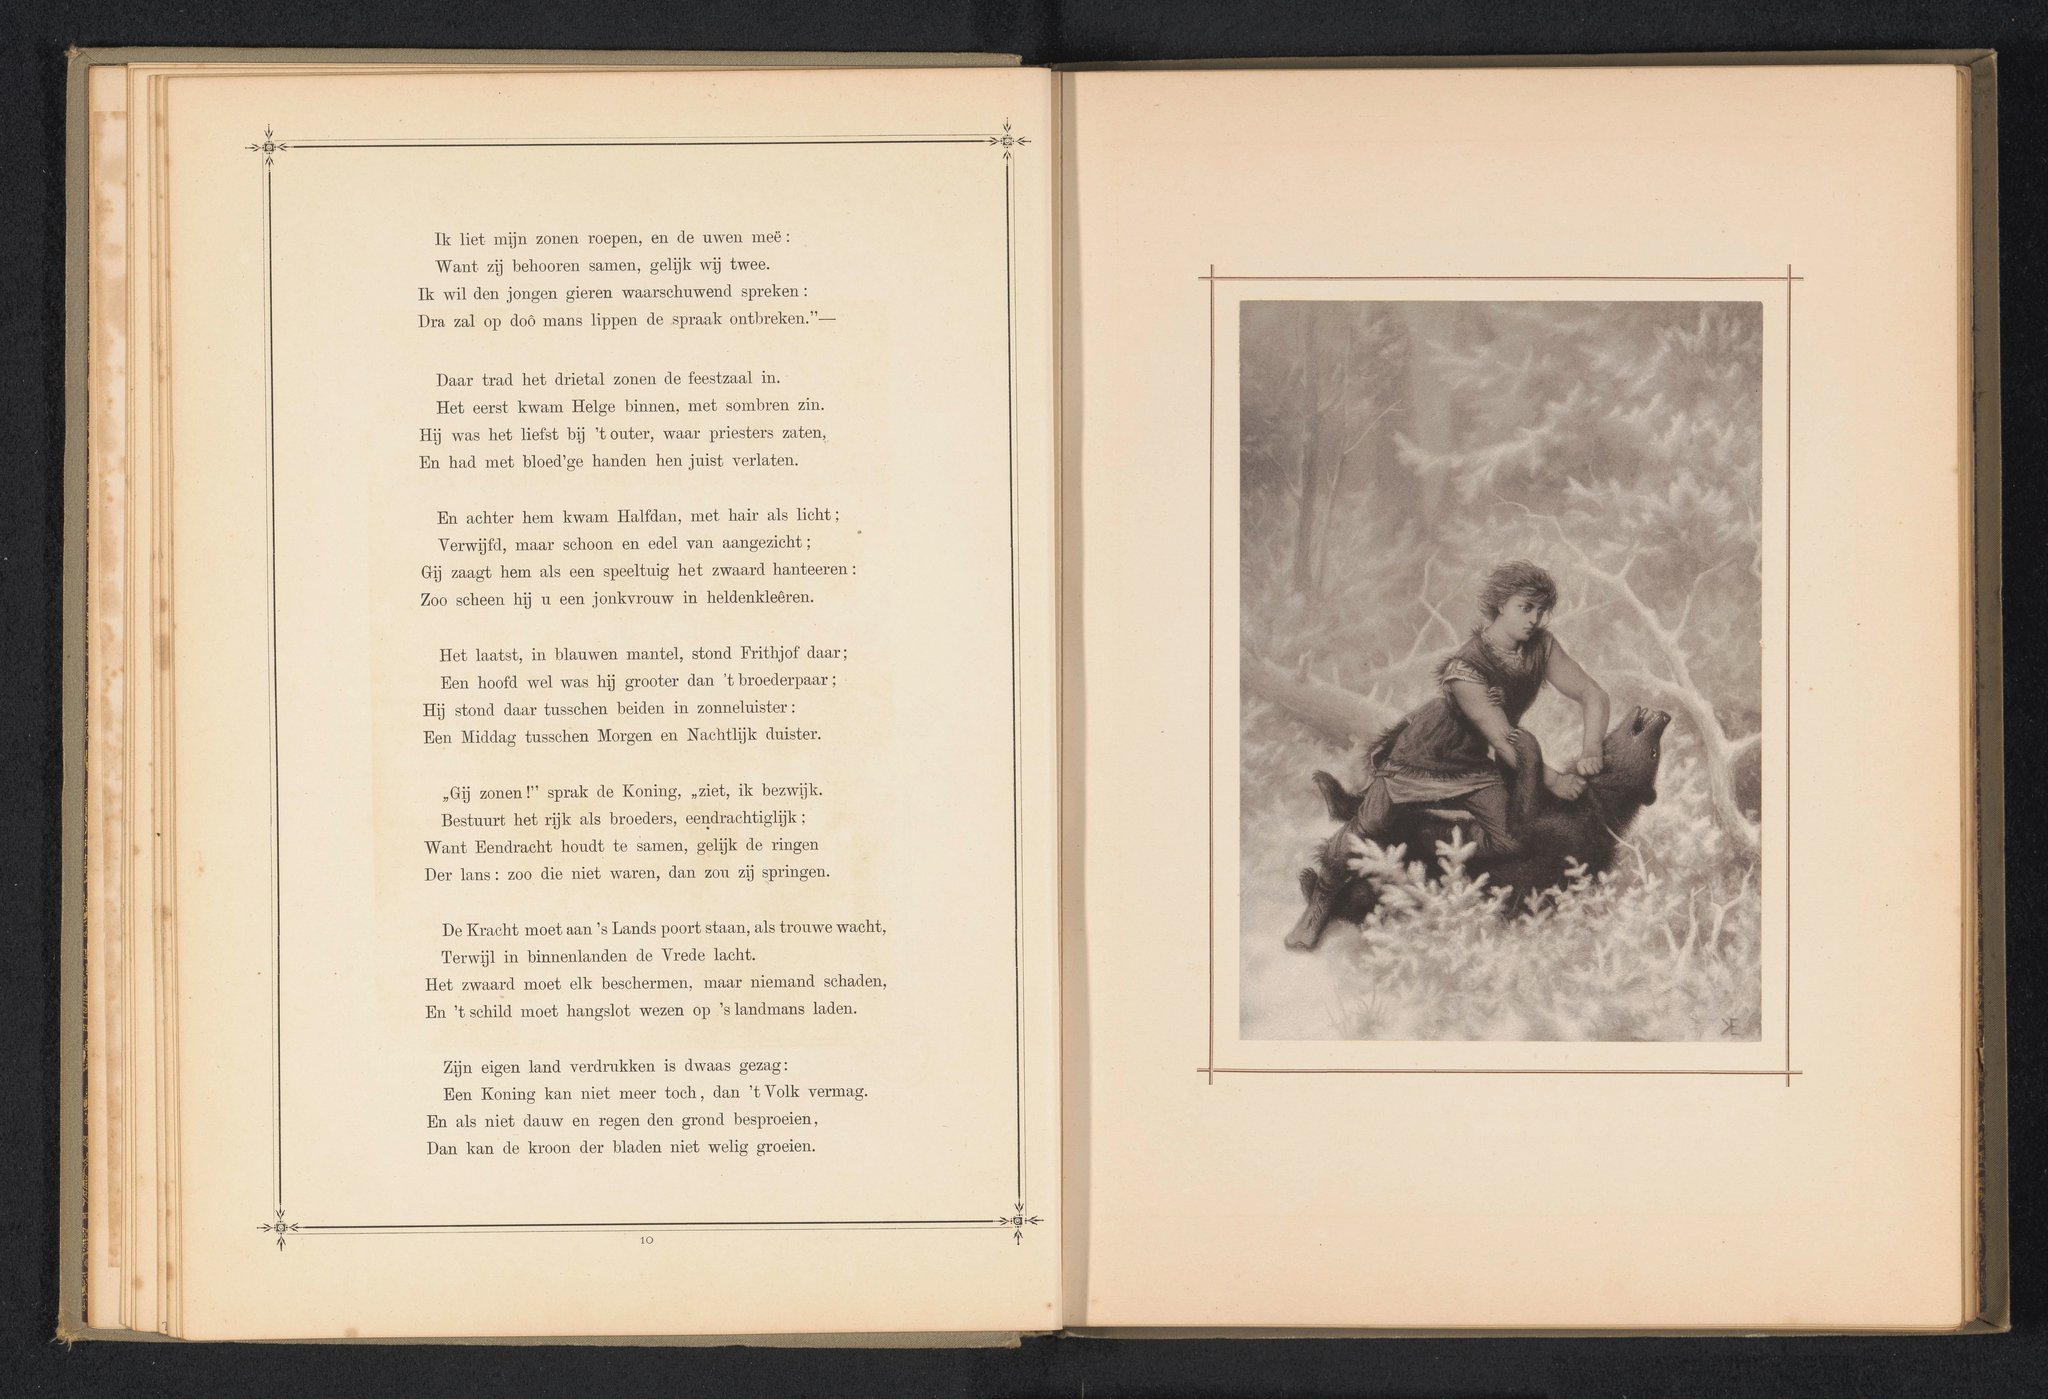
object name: reproduction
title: Fotoreproductie van een tekening van een jongen die met een beer vecht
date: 1872-1882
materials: paper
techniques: photograph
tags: beasts of prey, predatory animals: bear, fighting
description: Scene uit de Frithiof's Saga door Esaias Tegnér.